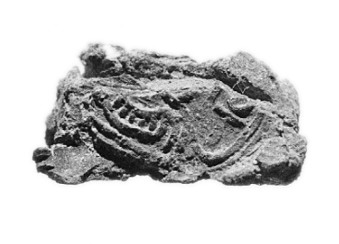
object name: sealing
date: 1981-1640 BCE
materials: mud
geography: egypt